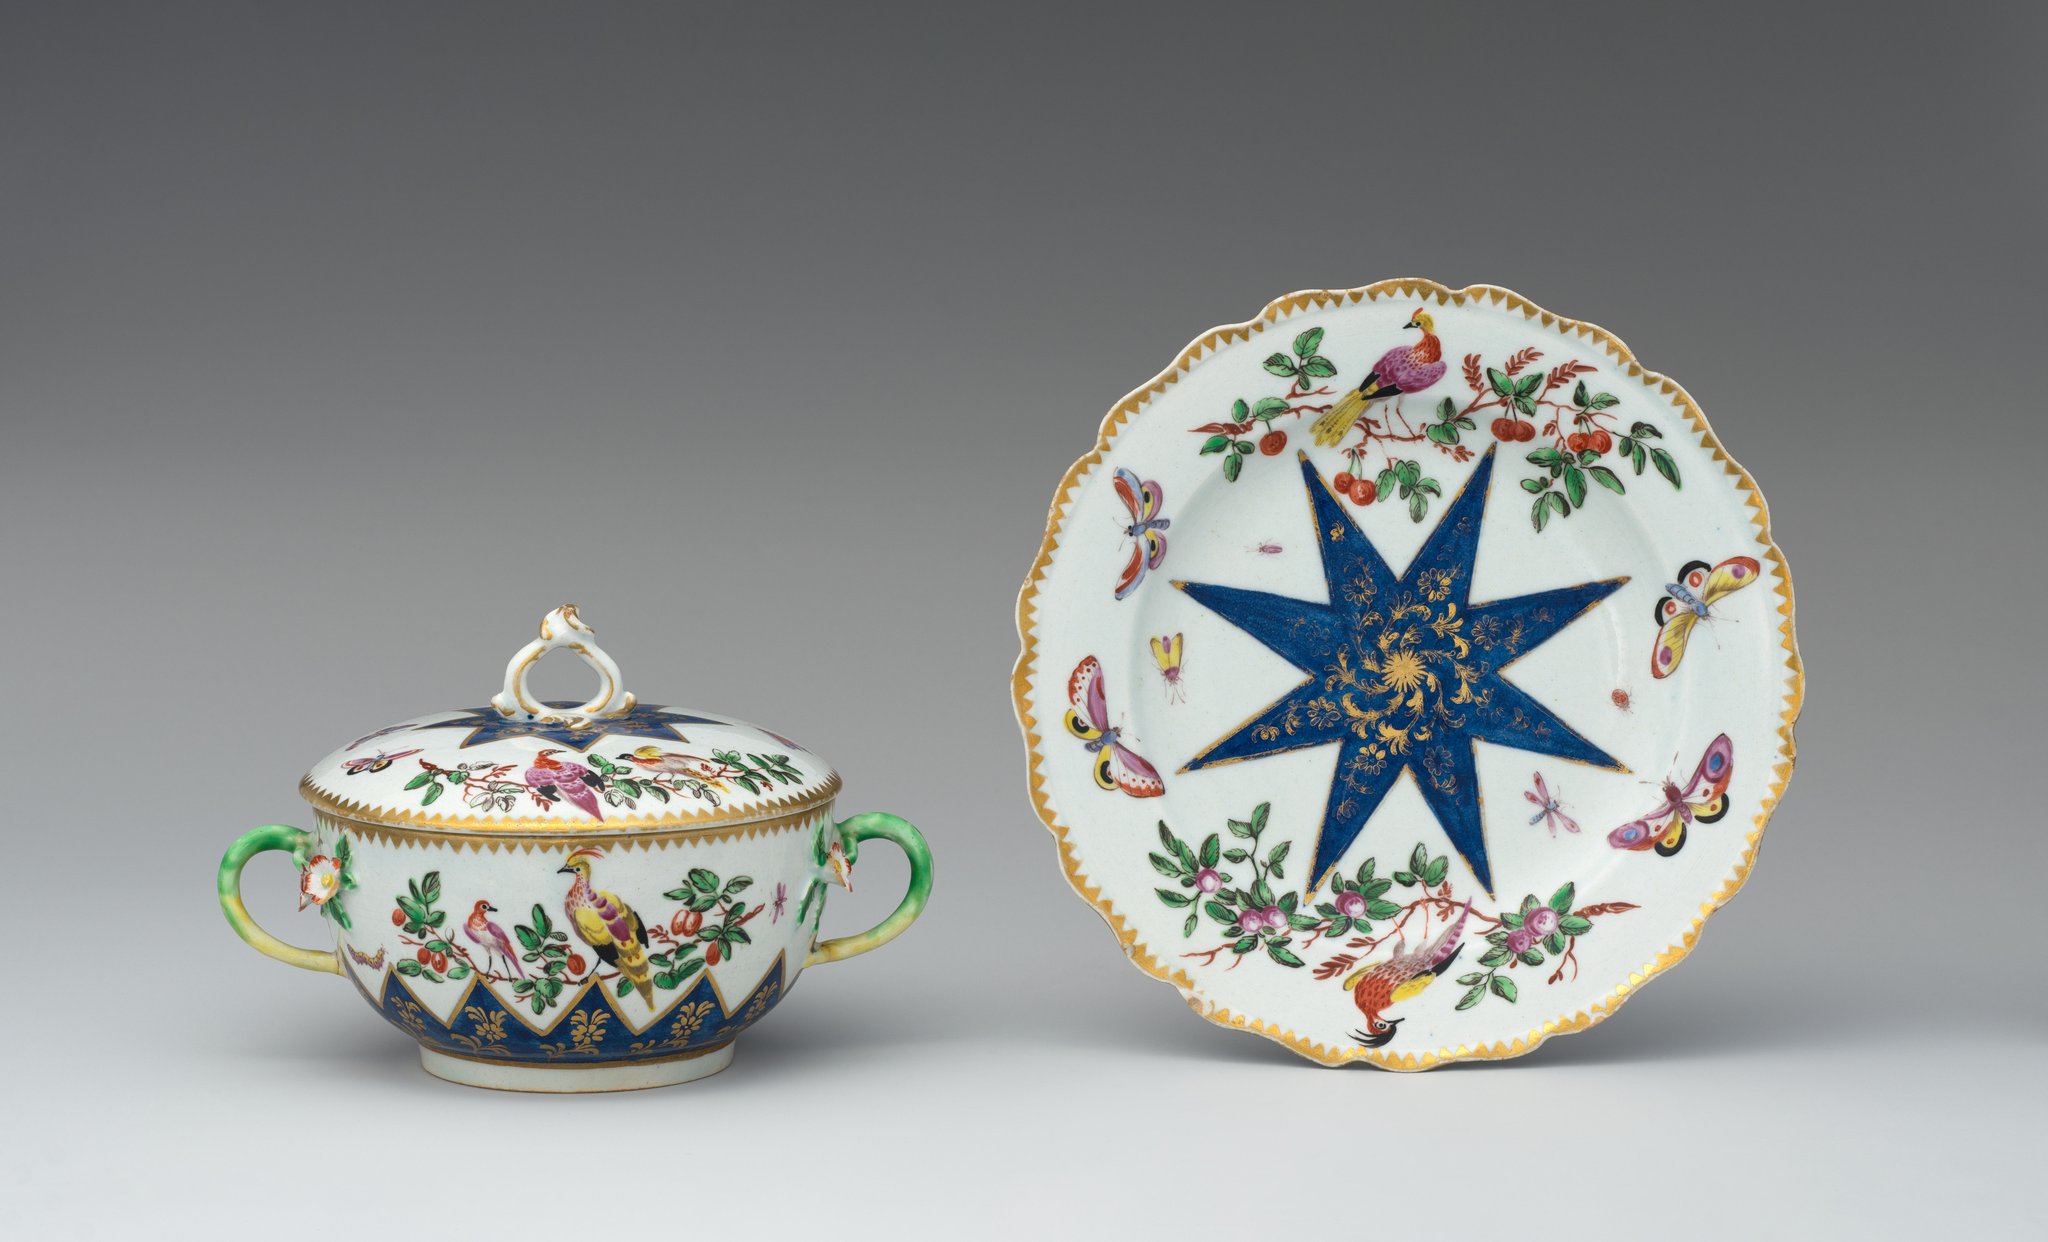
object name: écuelle with cover and underplate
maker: bow porcelain factory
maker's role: factory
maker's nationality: british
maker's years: 1747-1776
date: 1765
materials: soft paste porcelain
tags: birds,butterflies